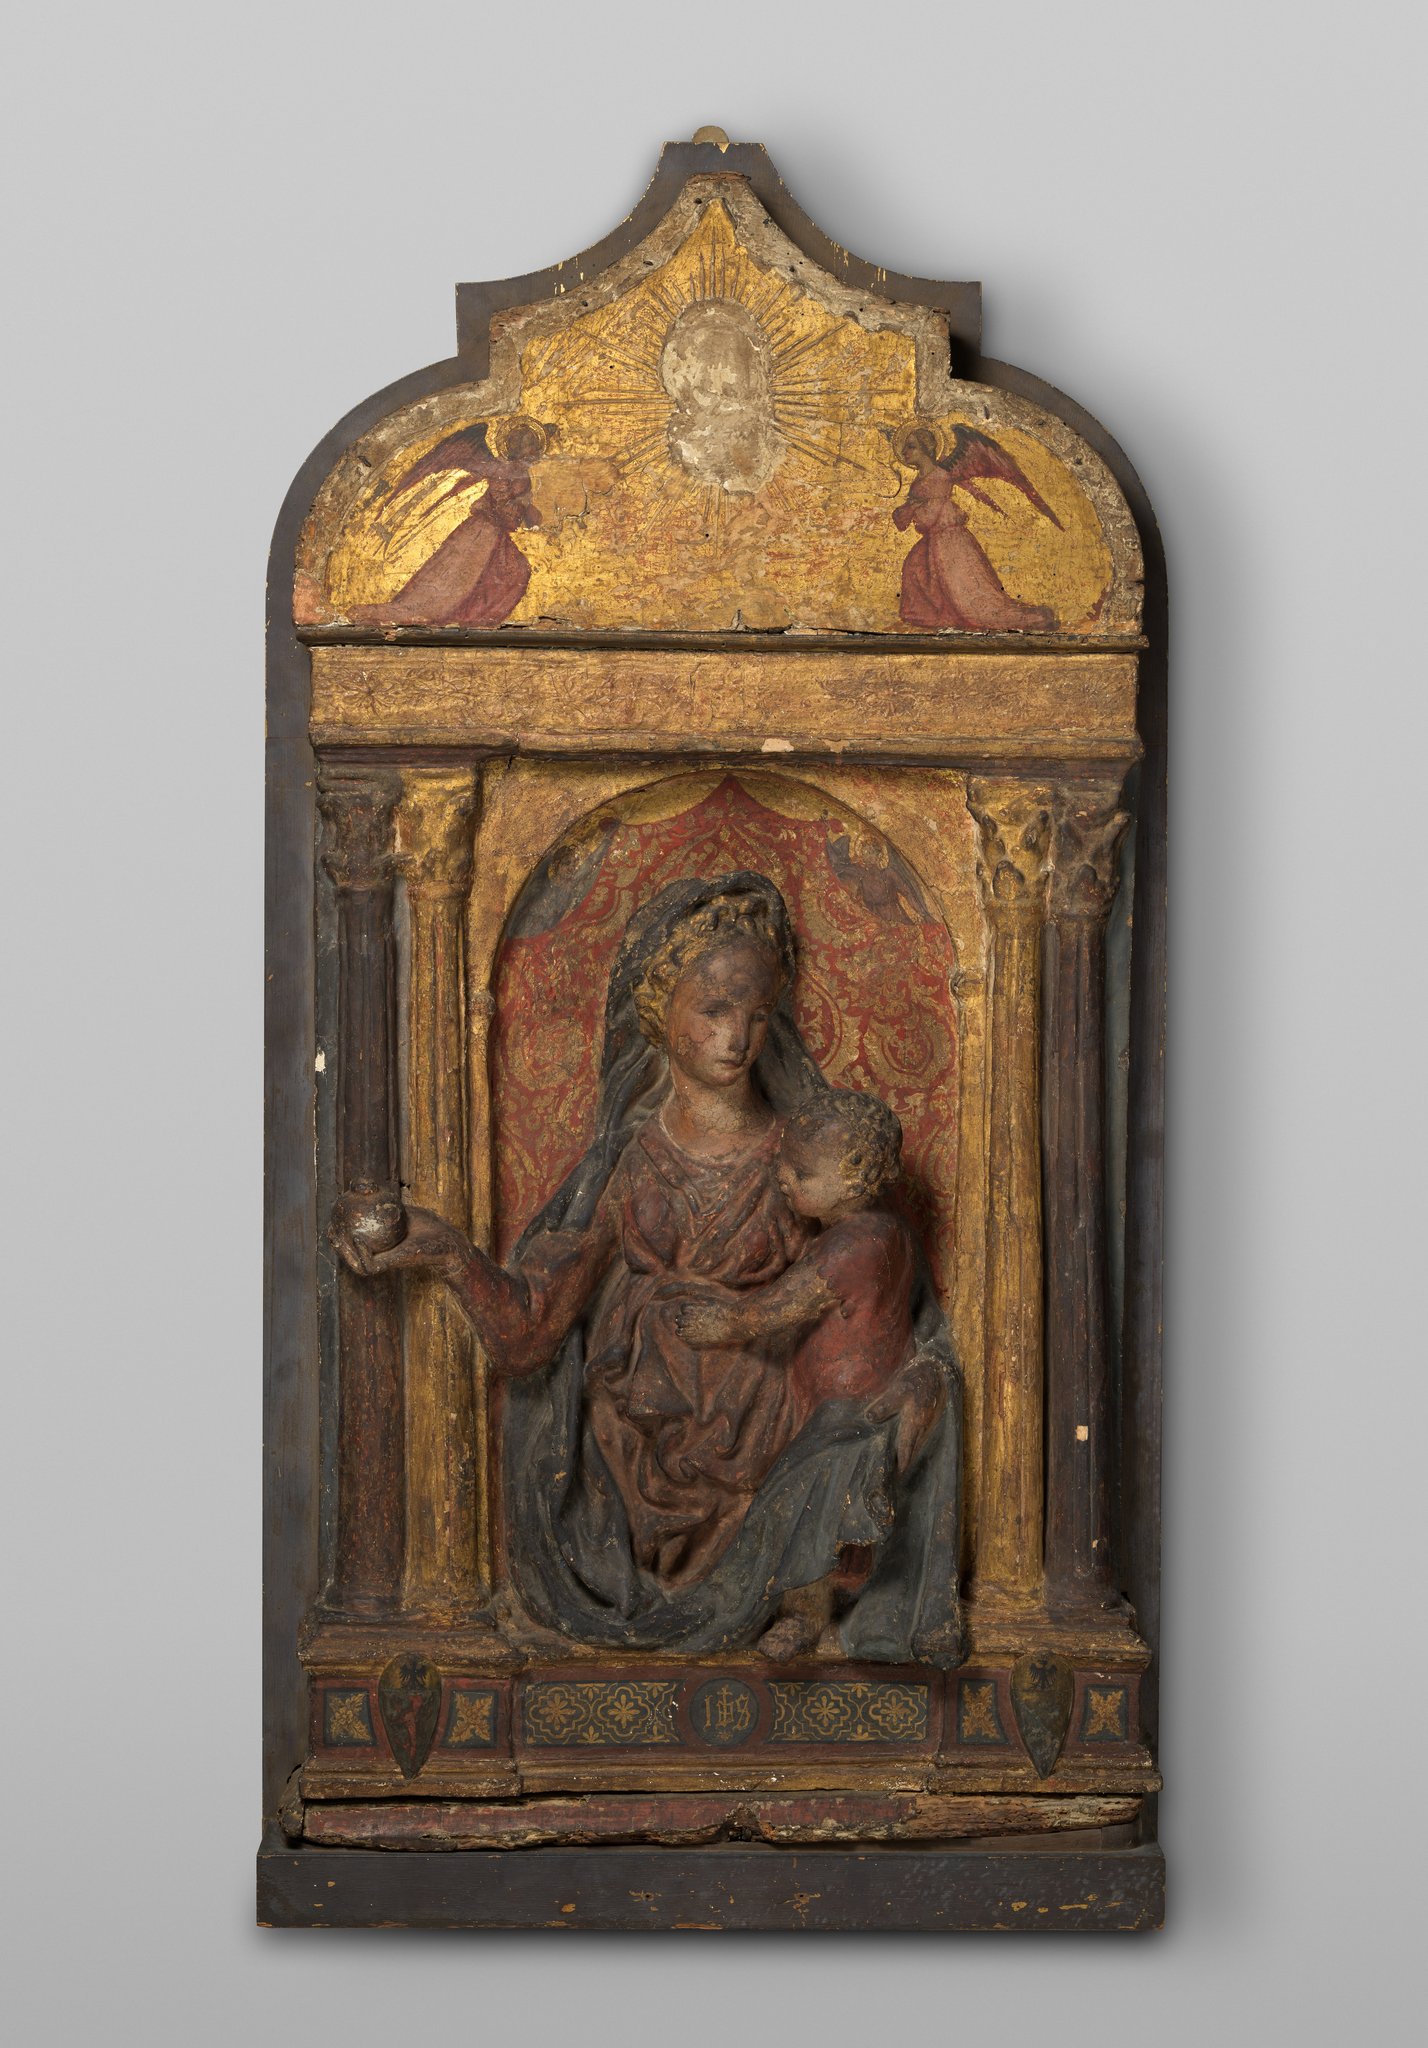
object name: relief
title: Madonna and Child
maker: master of the pellegrini chapel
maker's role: artist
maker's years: 1375-1475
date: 1430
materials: terracotta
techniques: gilding, polychrome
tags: angels,madonna and child